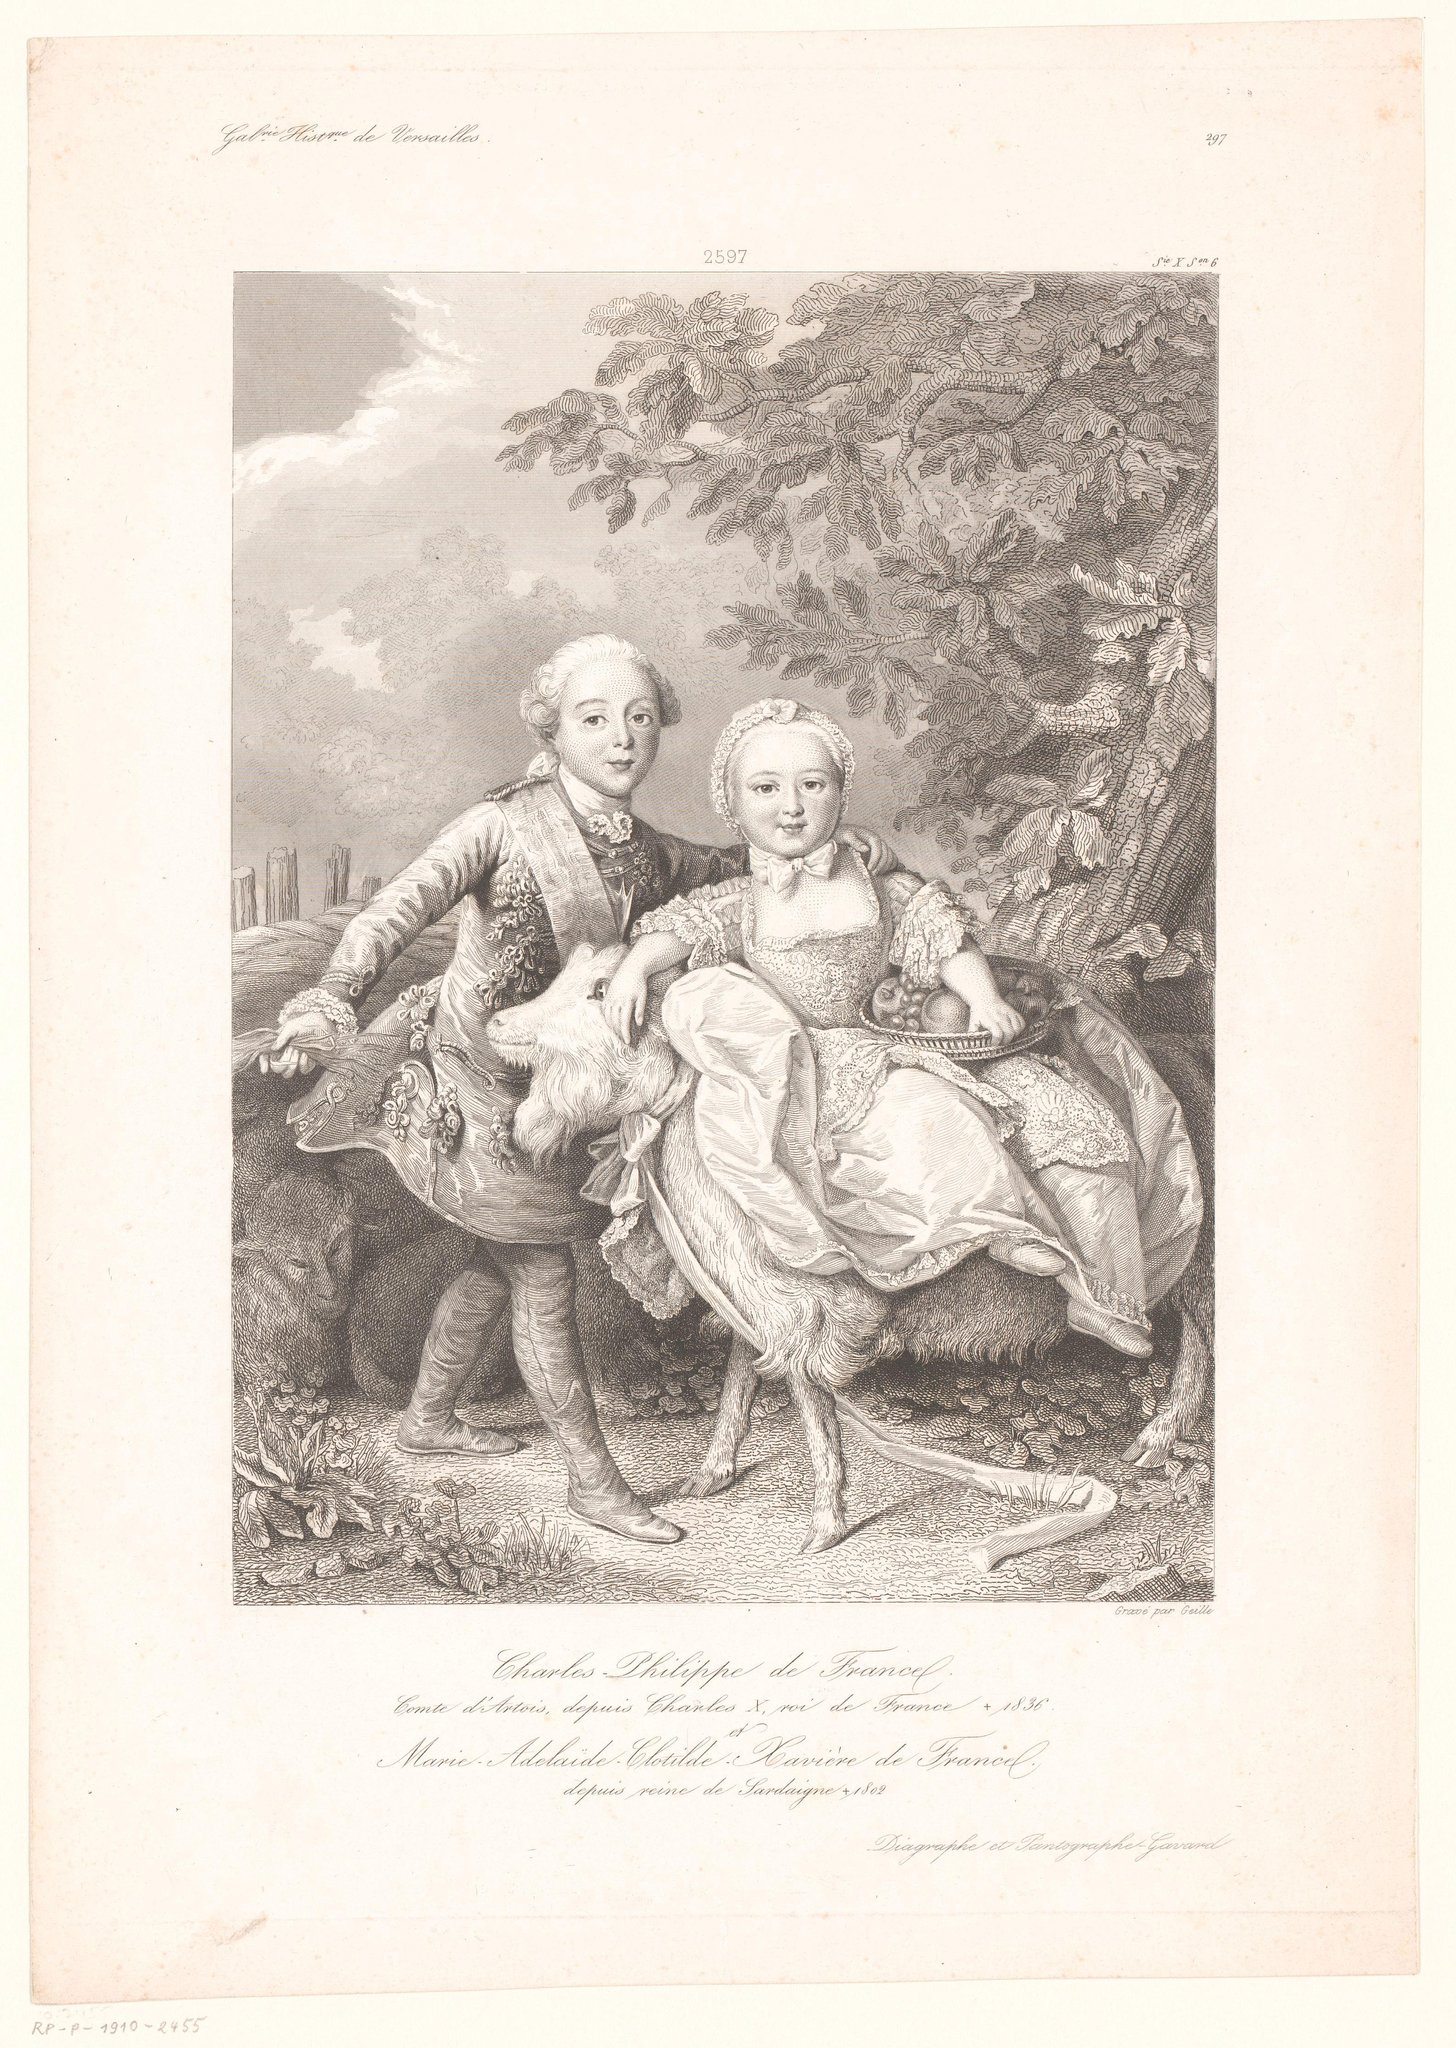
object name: book illustration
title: Portret van Karel X van Frankrijk en Clothilde van Frankrijk als kinderen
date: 1838-1841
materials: paper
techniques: engraving, etching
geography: paris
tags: clothilde van frankrijk, child, ruler, sovereign - bb - female ruler, ruler, sovereign, goat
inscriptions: collector's mark: Lugt 2228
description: Prent uit: Galeries historiques de Versailles. Parijs: Charles Gavard, 1838-1841, p. 297.